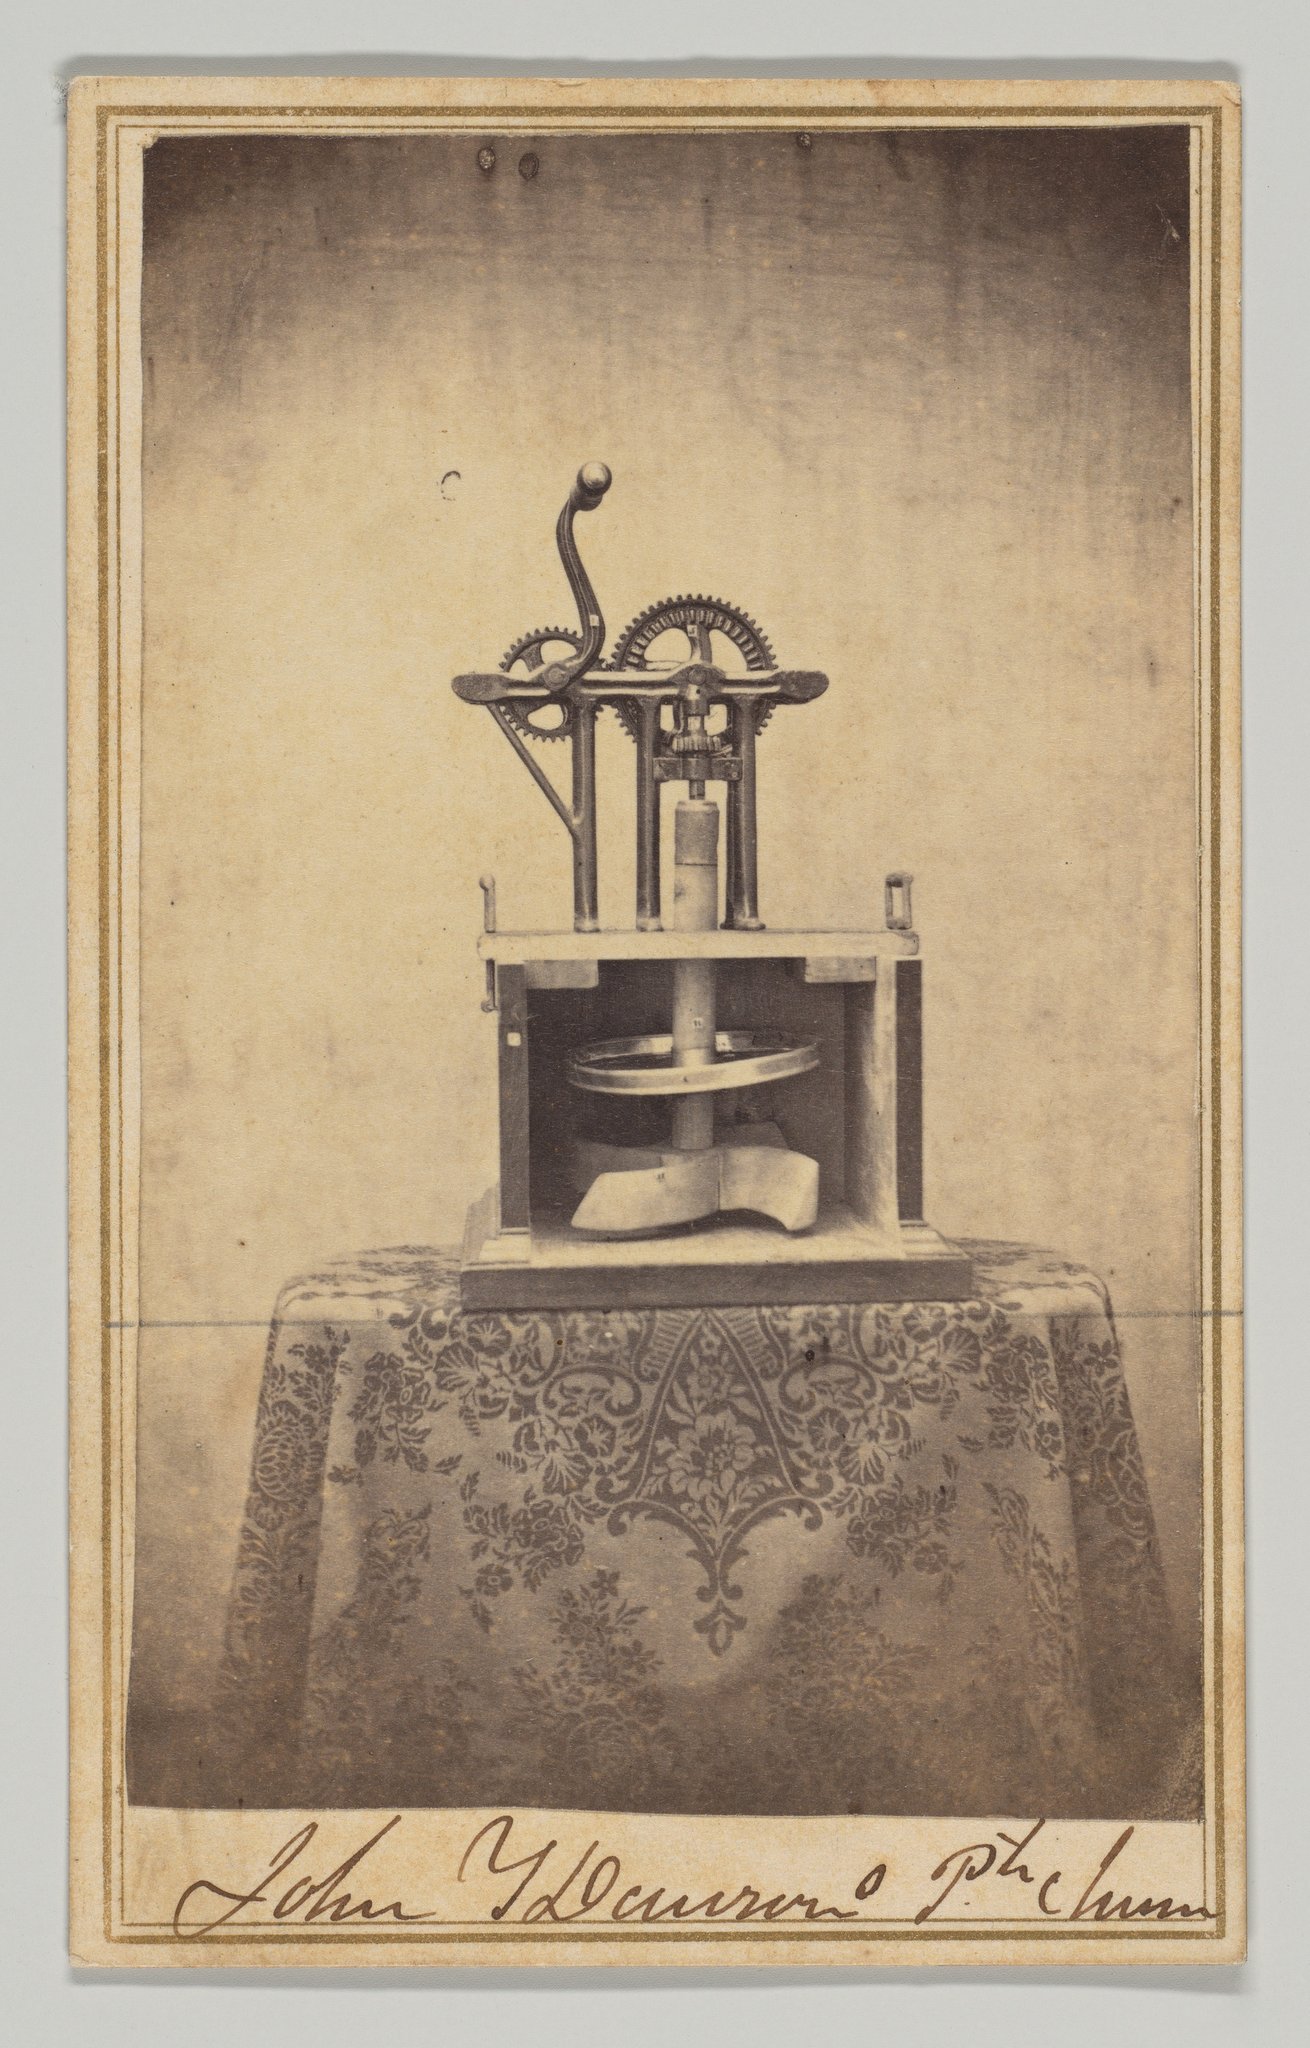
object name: photograph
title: [Paint Churn on Table]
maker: Anonymous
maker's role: artist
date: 1860-1869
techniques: albumen silver print